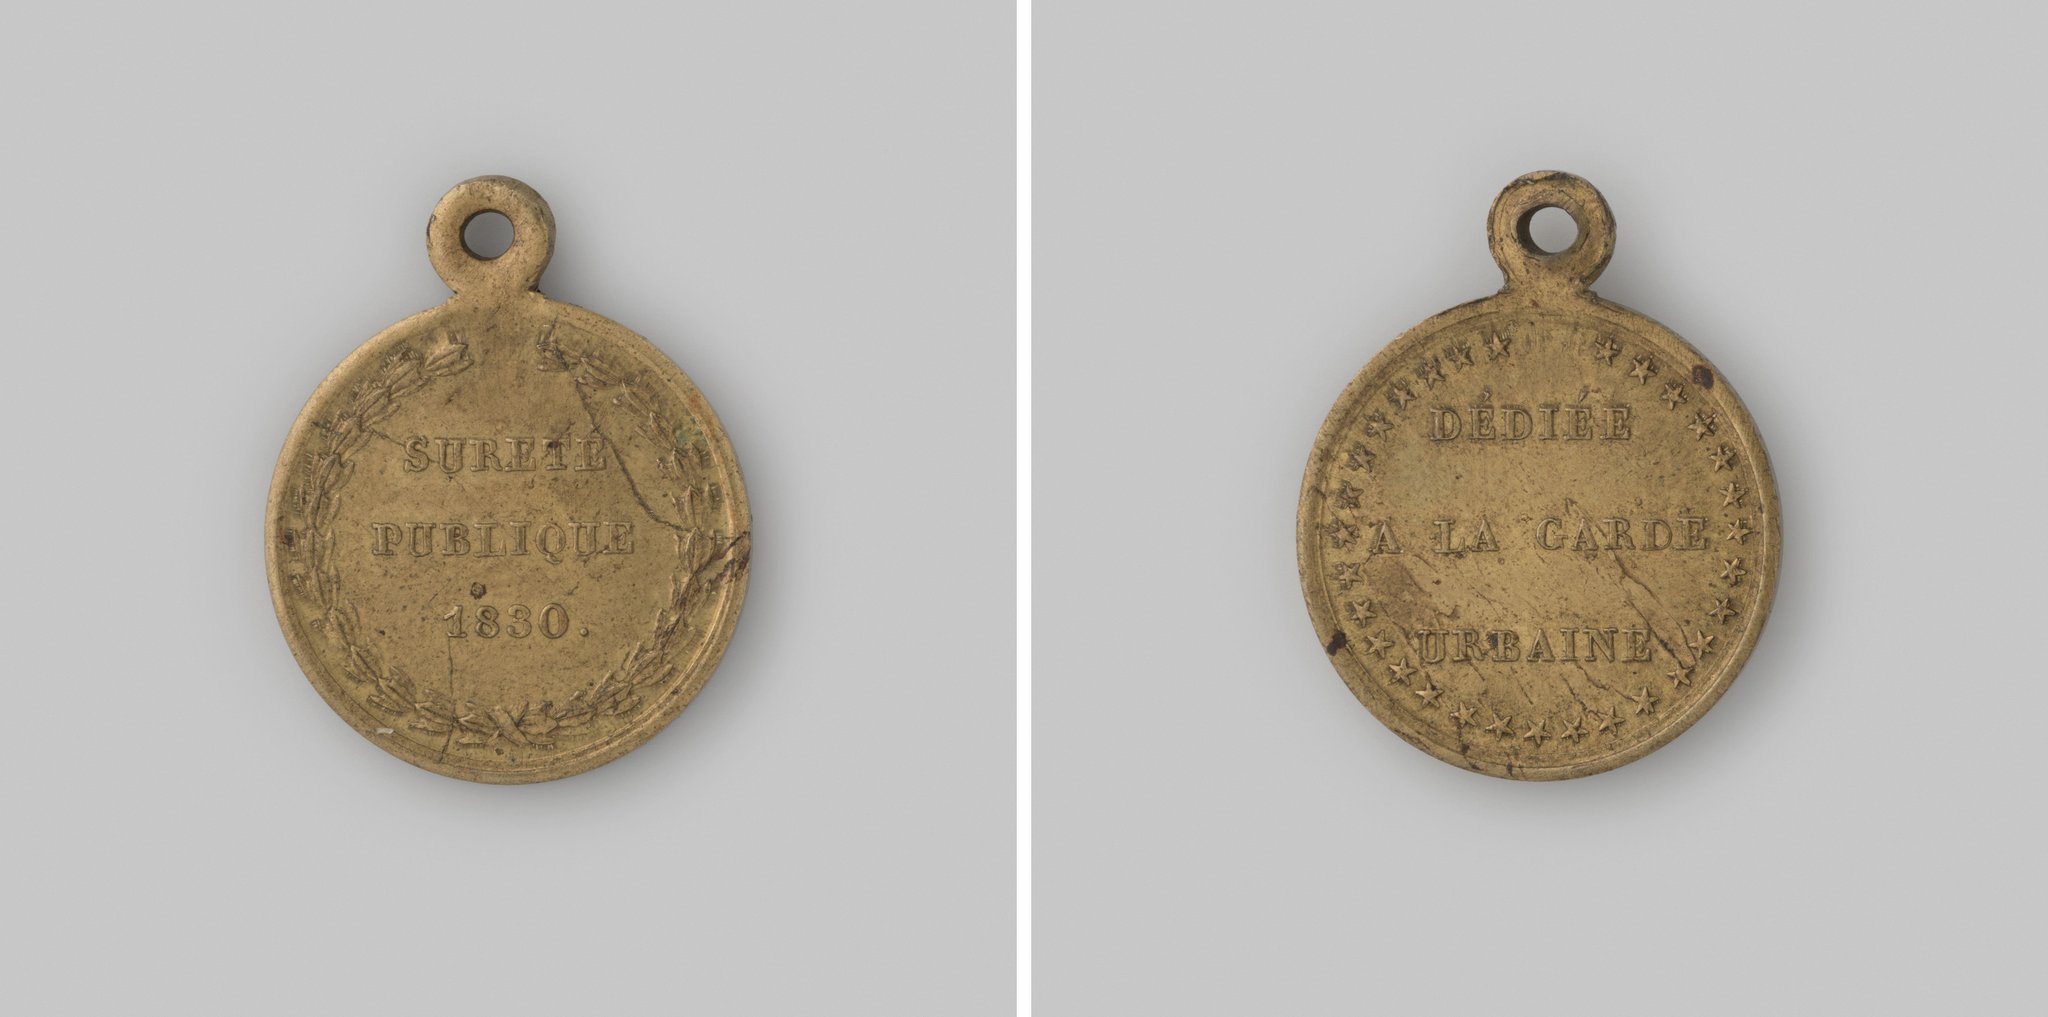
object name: history medal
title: Brusselse Burgerwacht 1830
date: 1830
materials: brass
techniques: striking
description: Messing penning met draagoog, op de voorzijde drie regels tekst binnen een lauwerkrans, op de keerzijde drie regels tekst binnen een lauwerkrans.